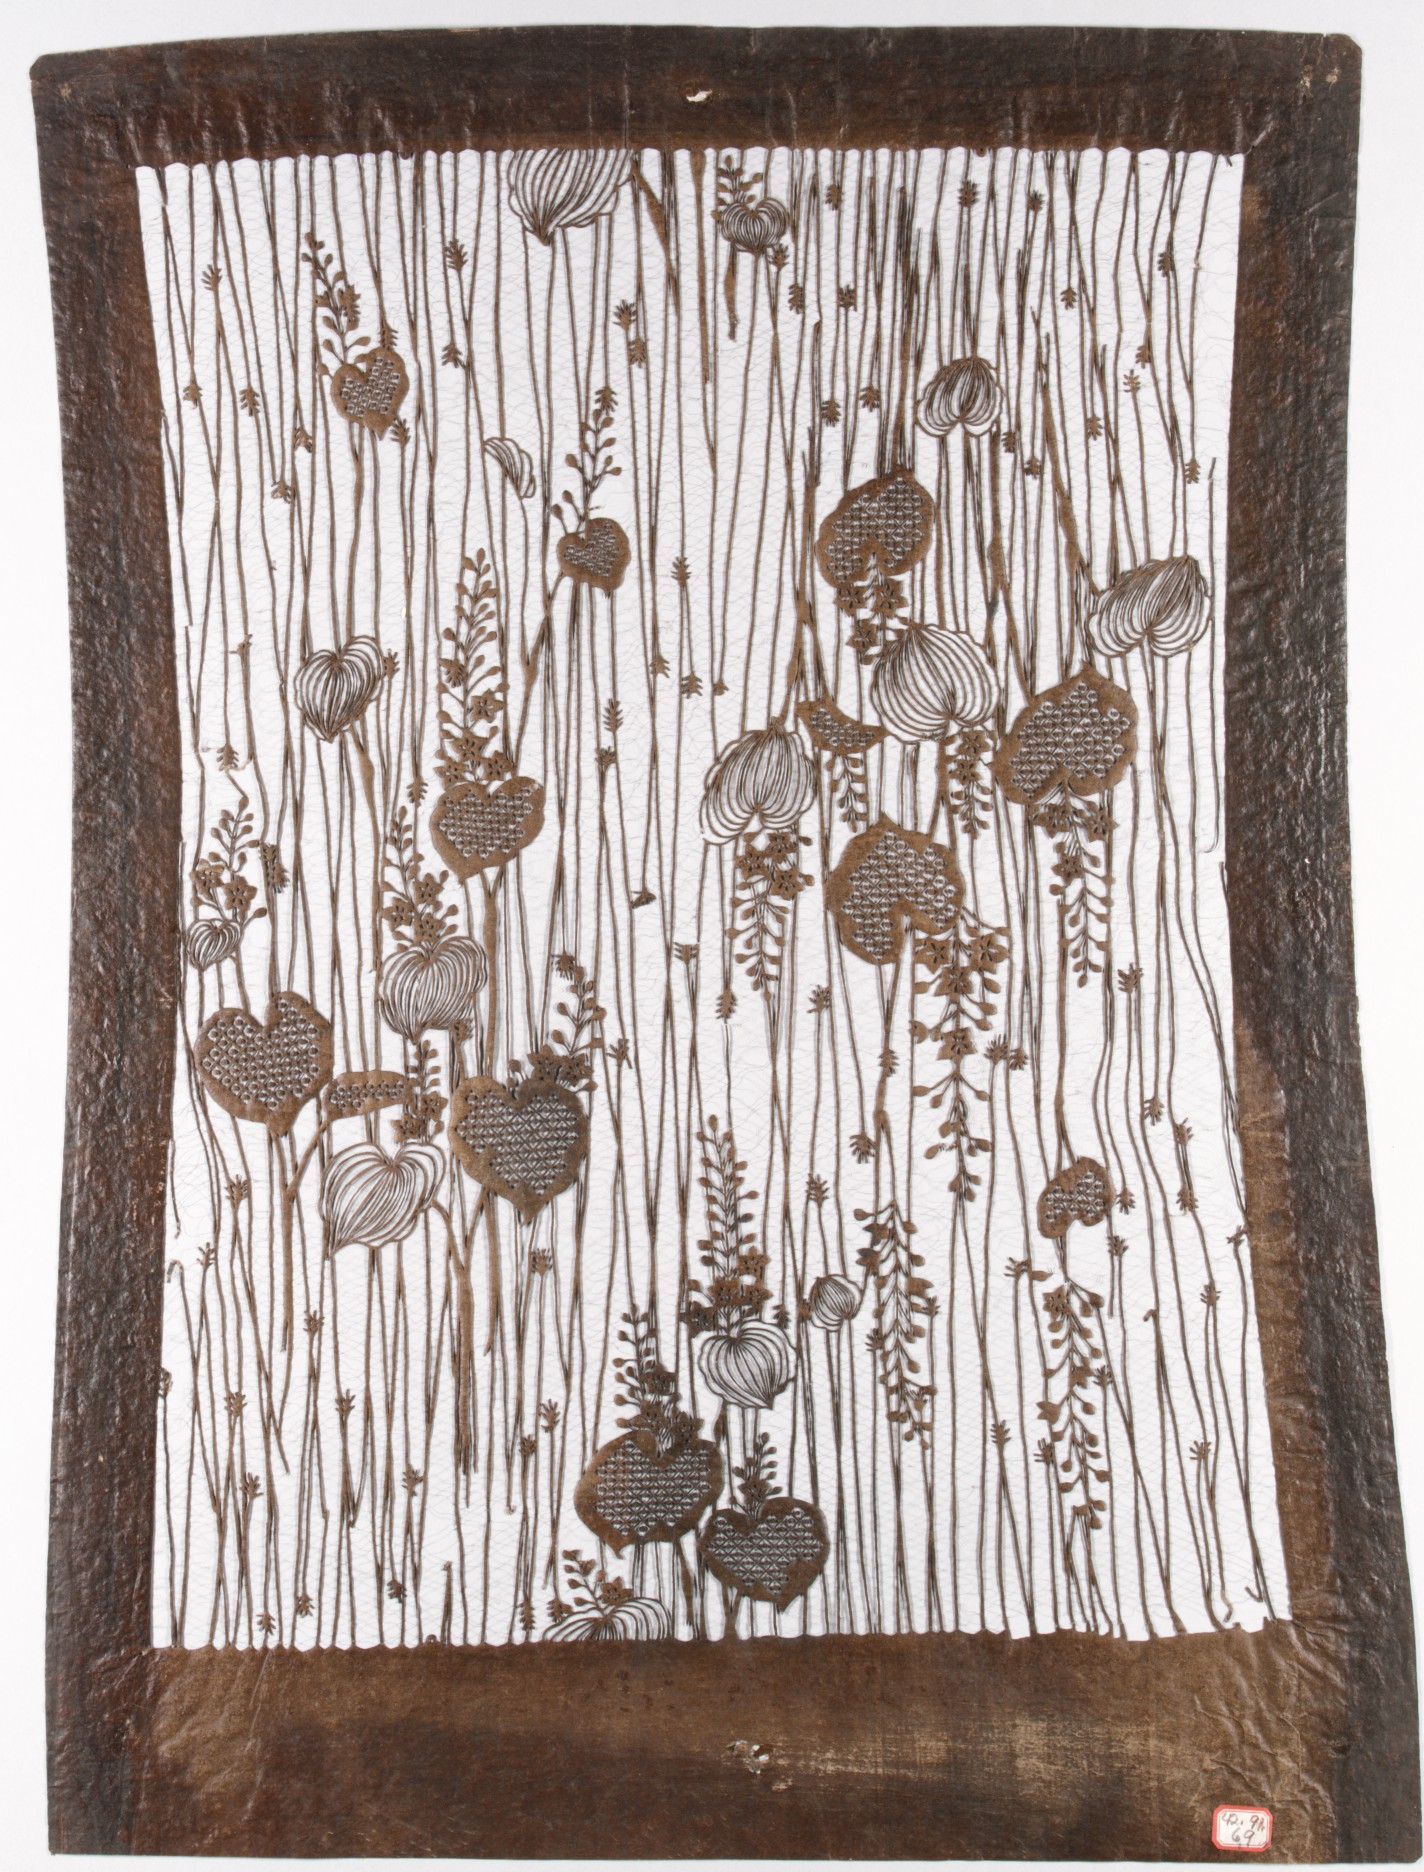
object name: stencil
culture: japanese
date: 1801-1900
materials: paper, silk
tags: flowers